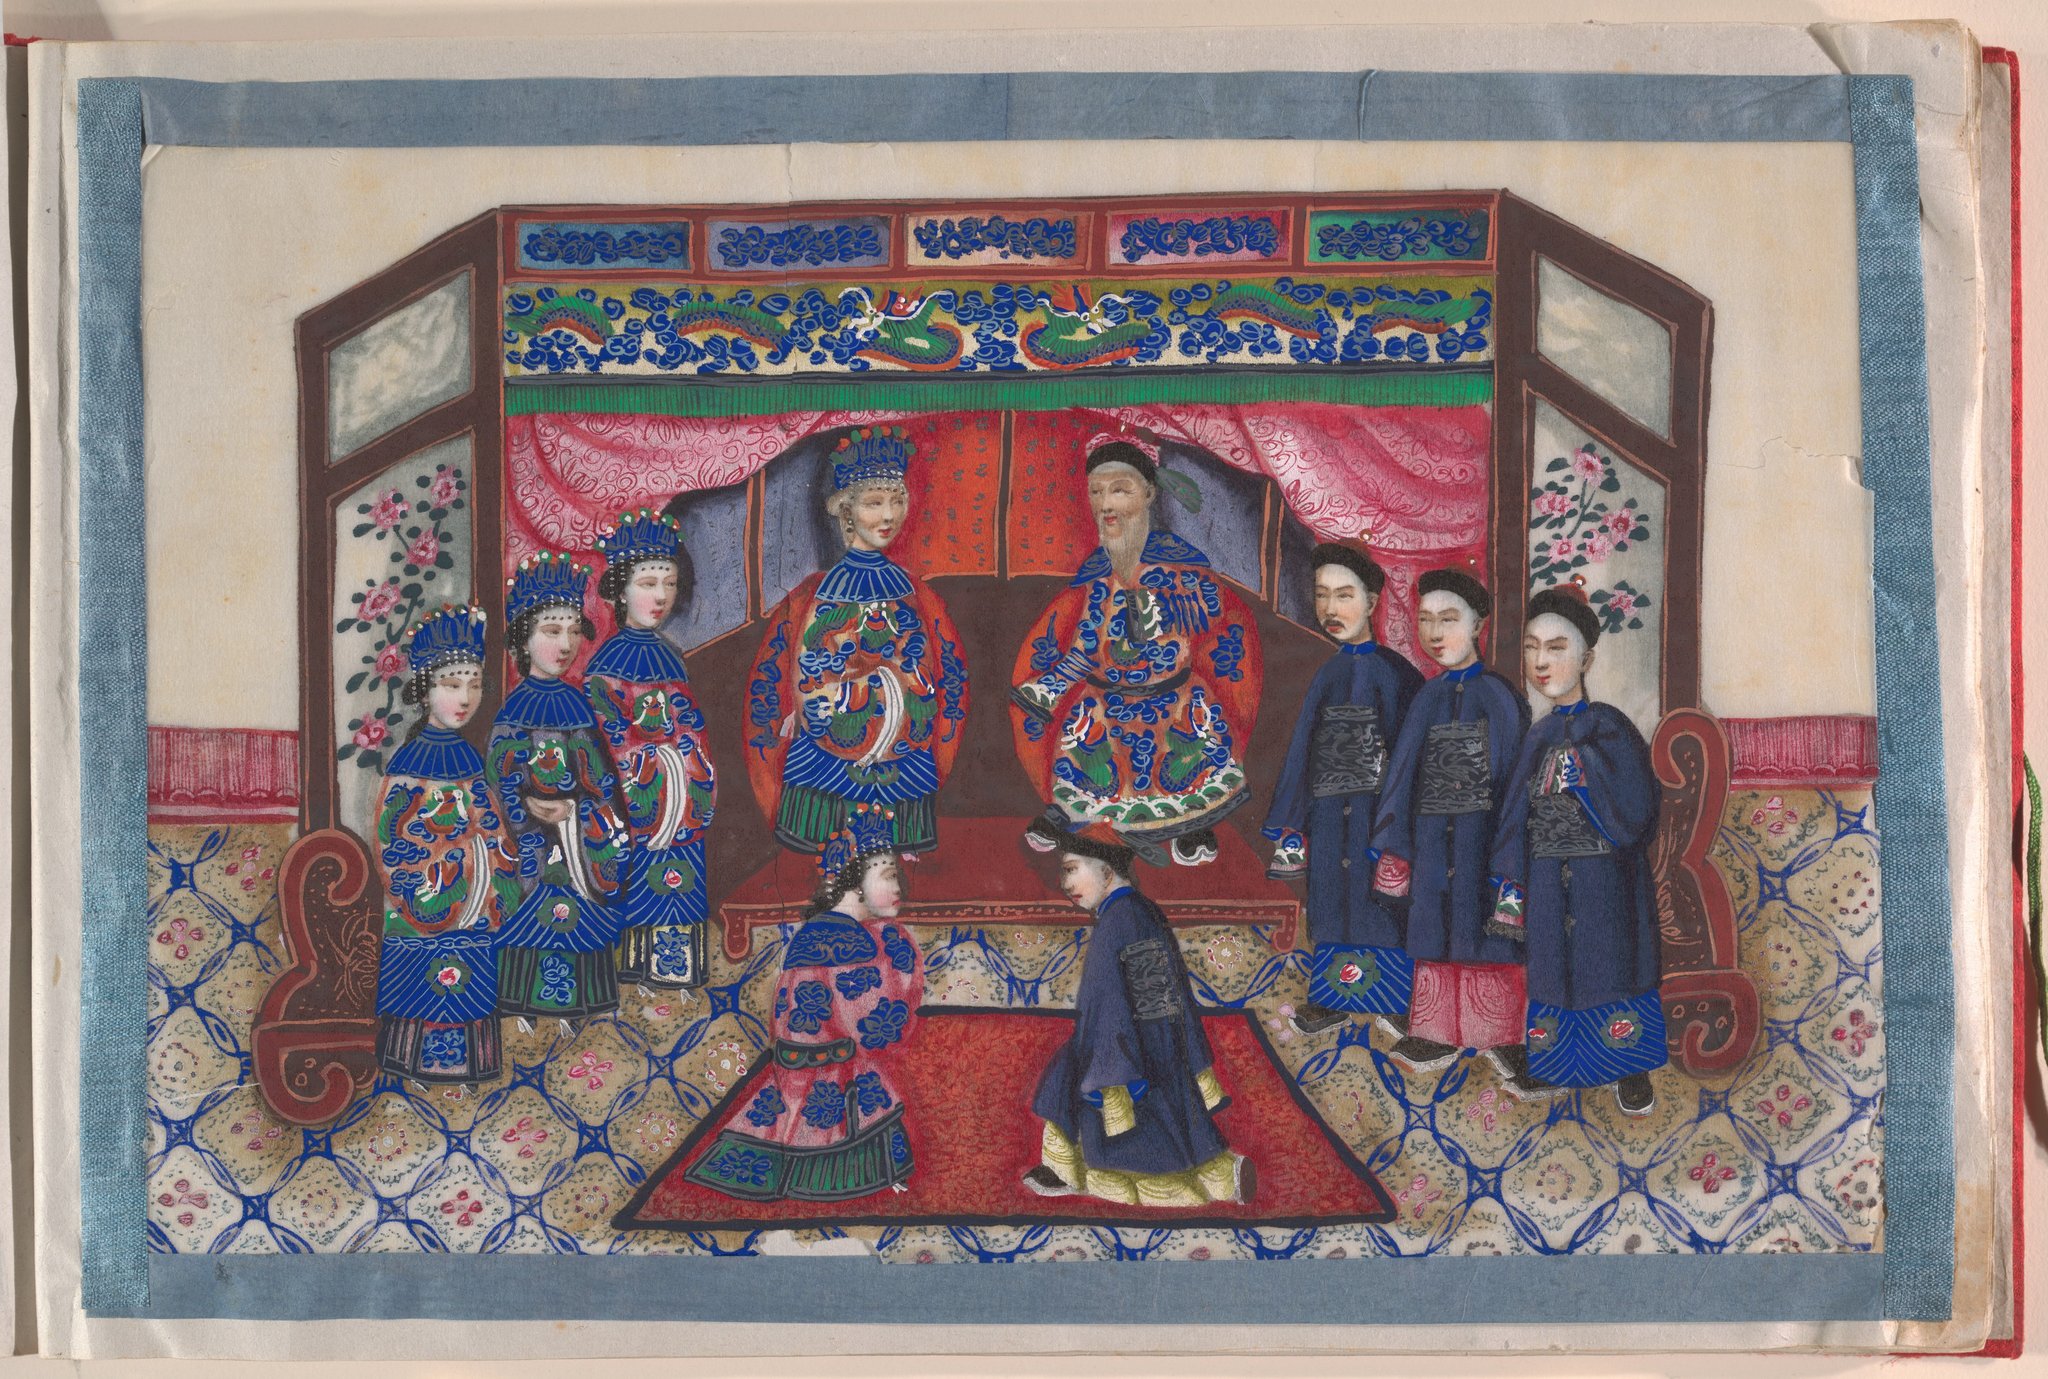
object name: album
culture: chinese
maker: unidentified artist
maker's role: artist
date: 1867-1900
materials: ink, paper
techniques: bookbinding, damask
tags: men,women